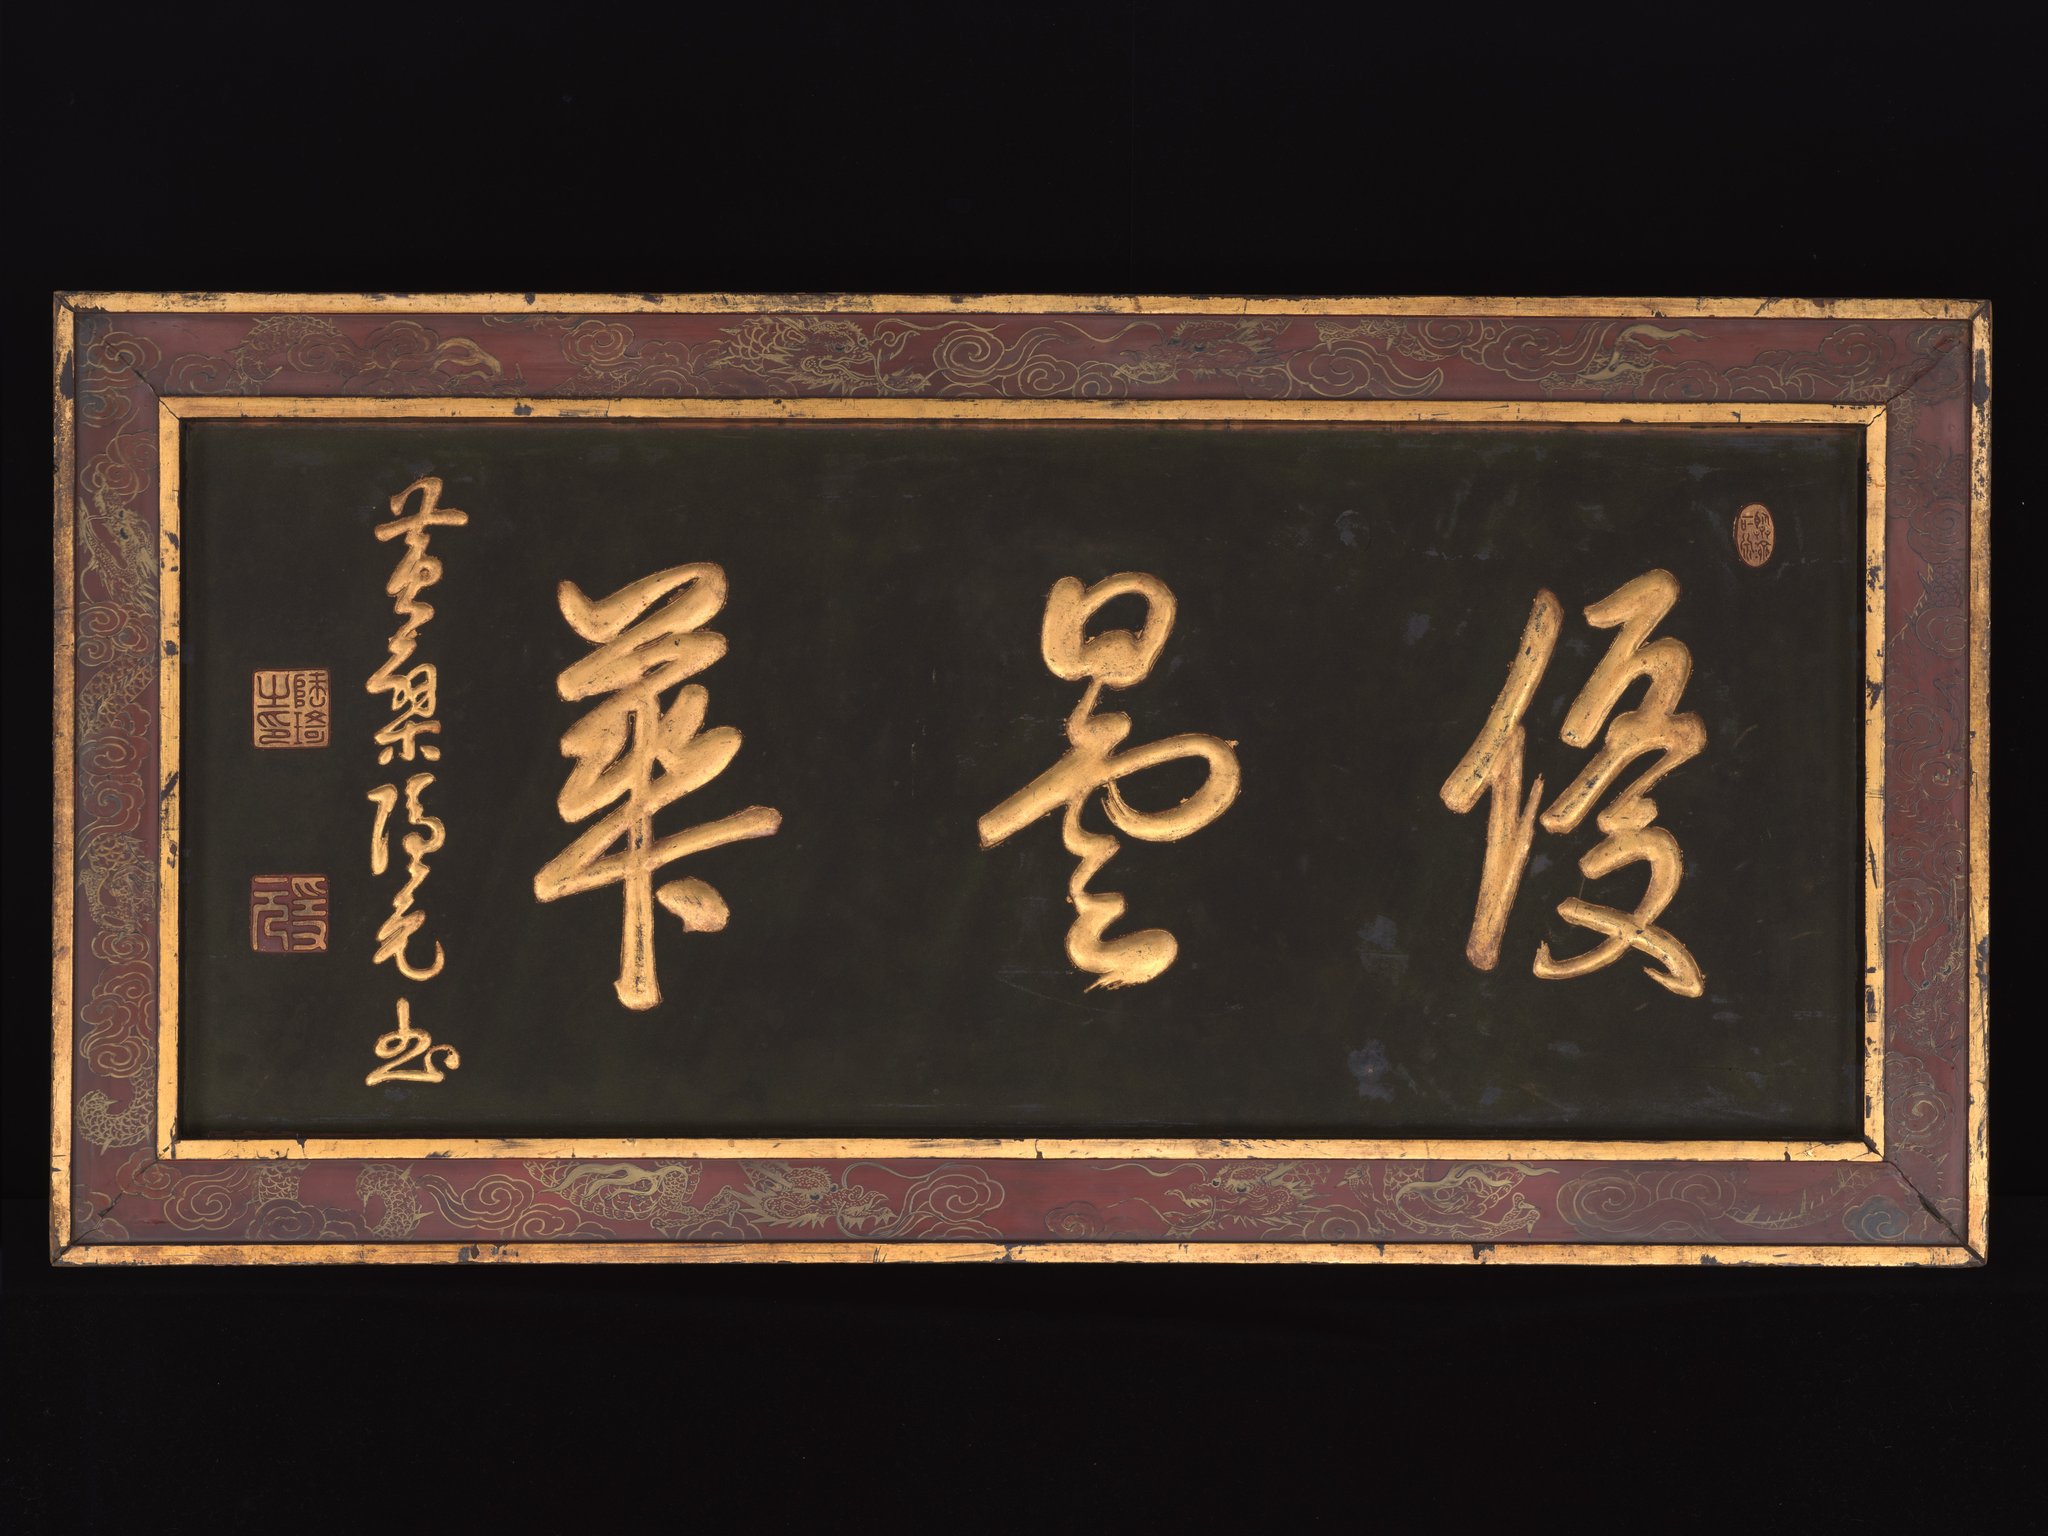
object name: temple plaque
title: “Udumbara Flowers” (Udonge) Temple Plaque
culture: japanese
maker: yinyuan longqi (ingen ryūki)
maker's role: artist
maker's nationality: chinese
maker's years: 1592-1673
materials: gold, lacquer, wood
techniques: carving